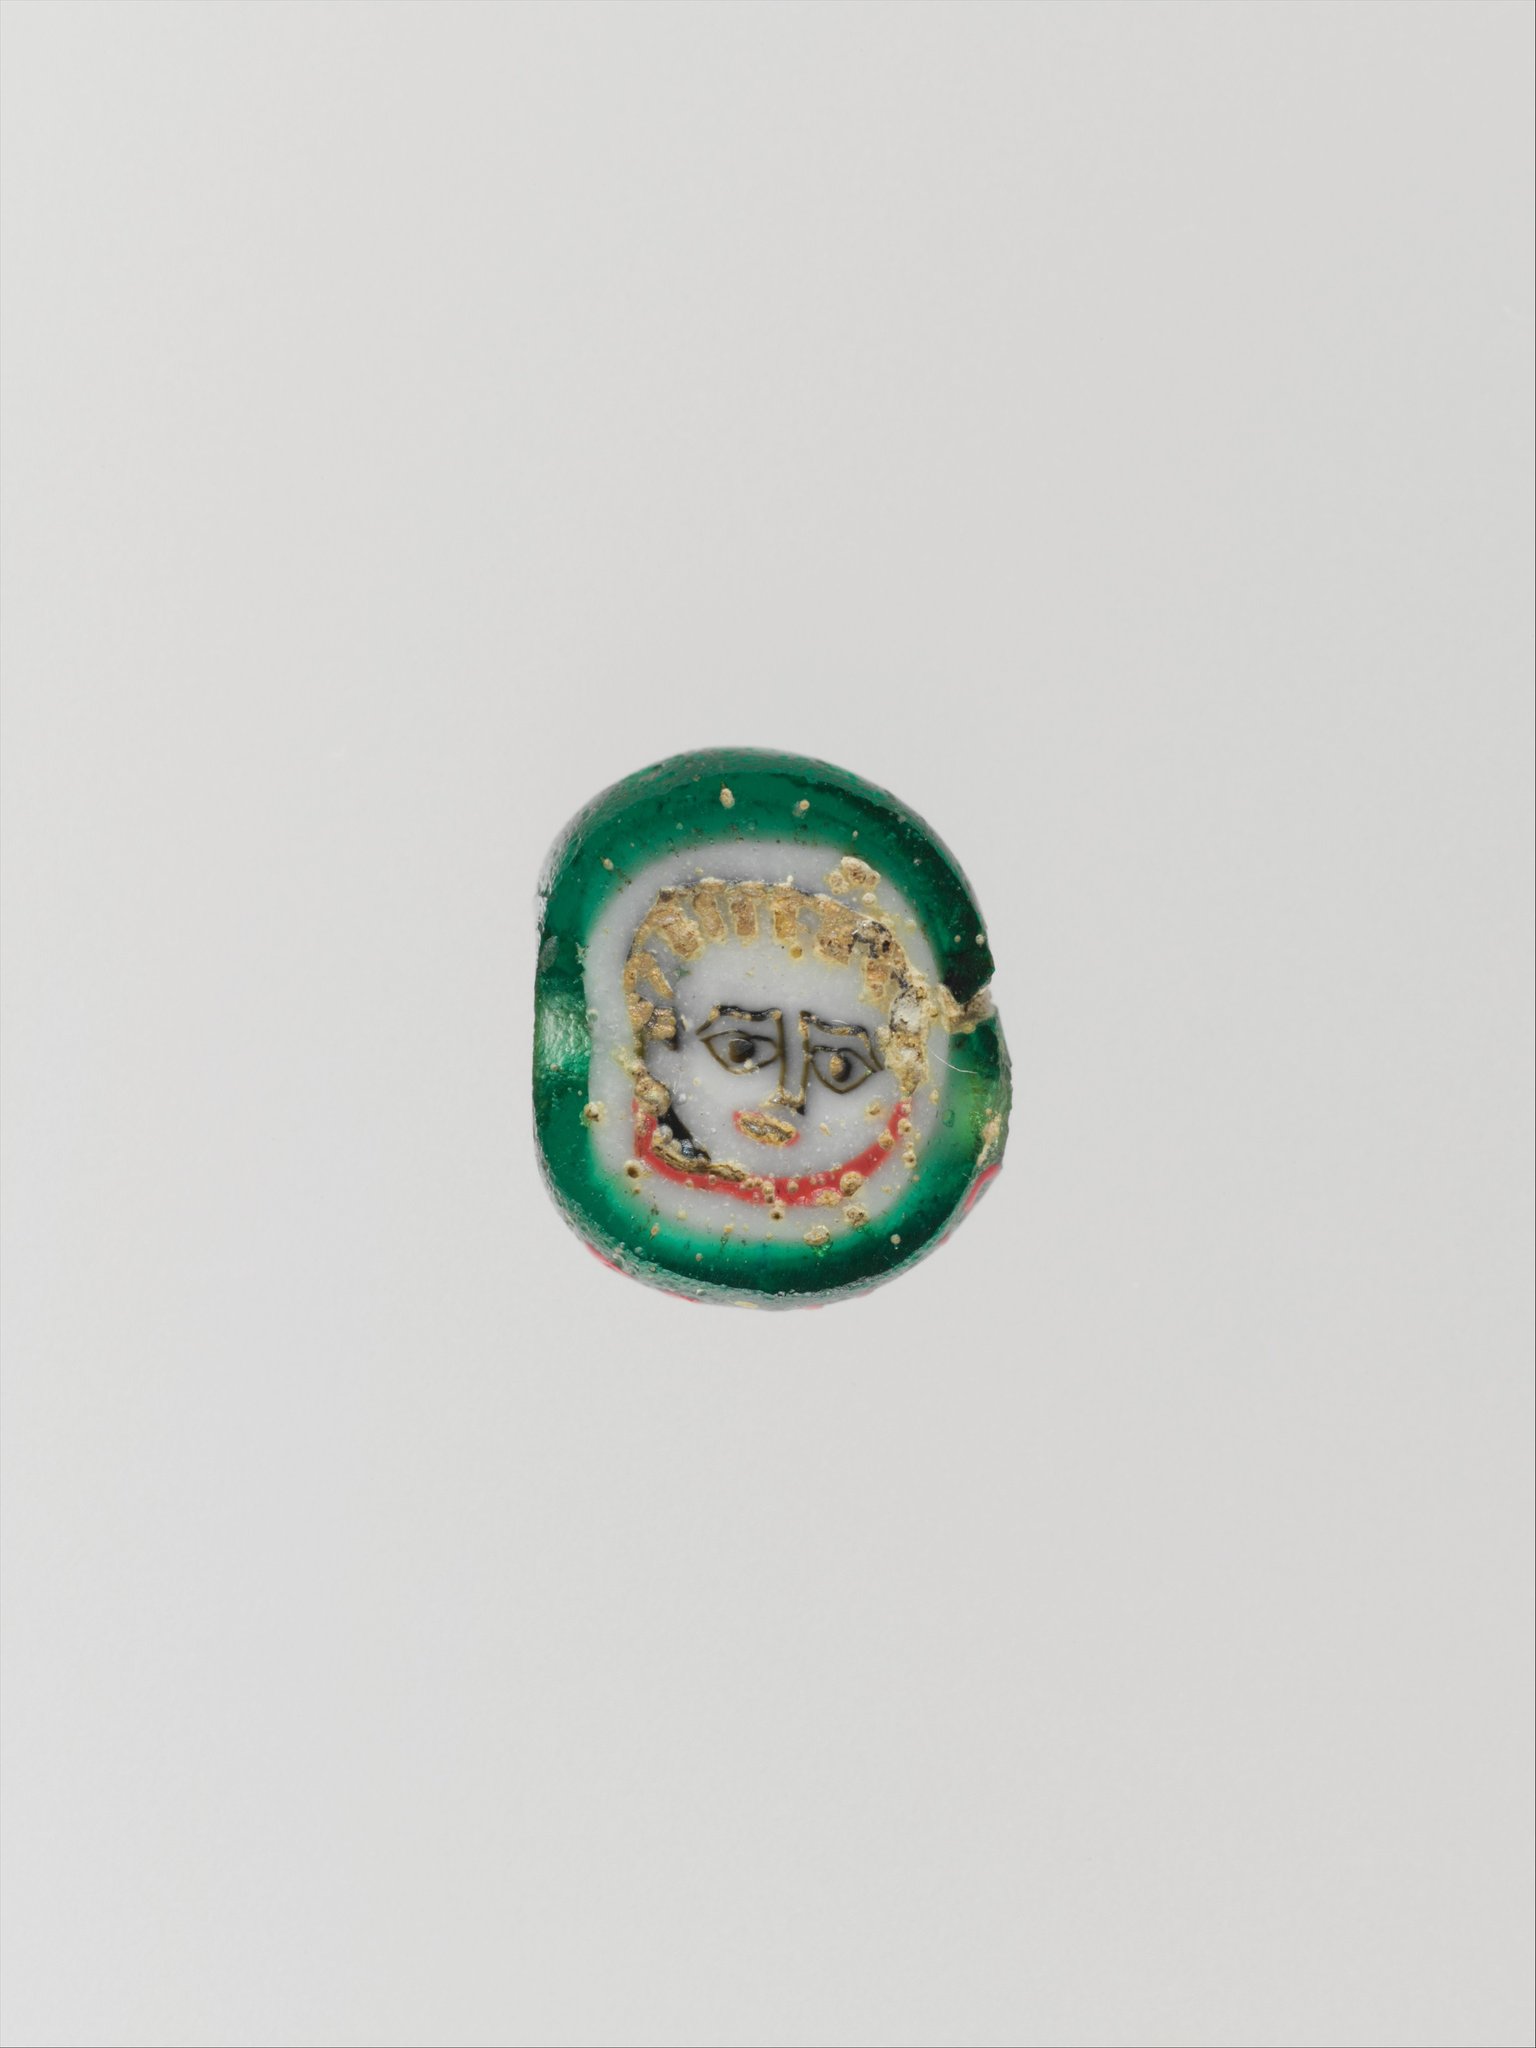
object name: face bead, discoid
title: Glass mosaic face bead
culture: roman, eastern mediterranean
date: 100 BCE-100 CE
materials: glass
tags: faces